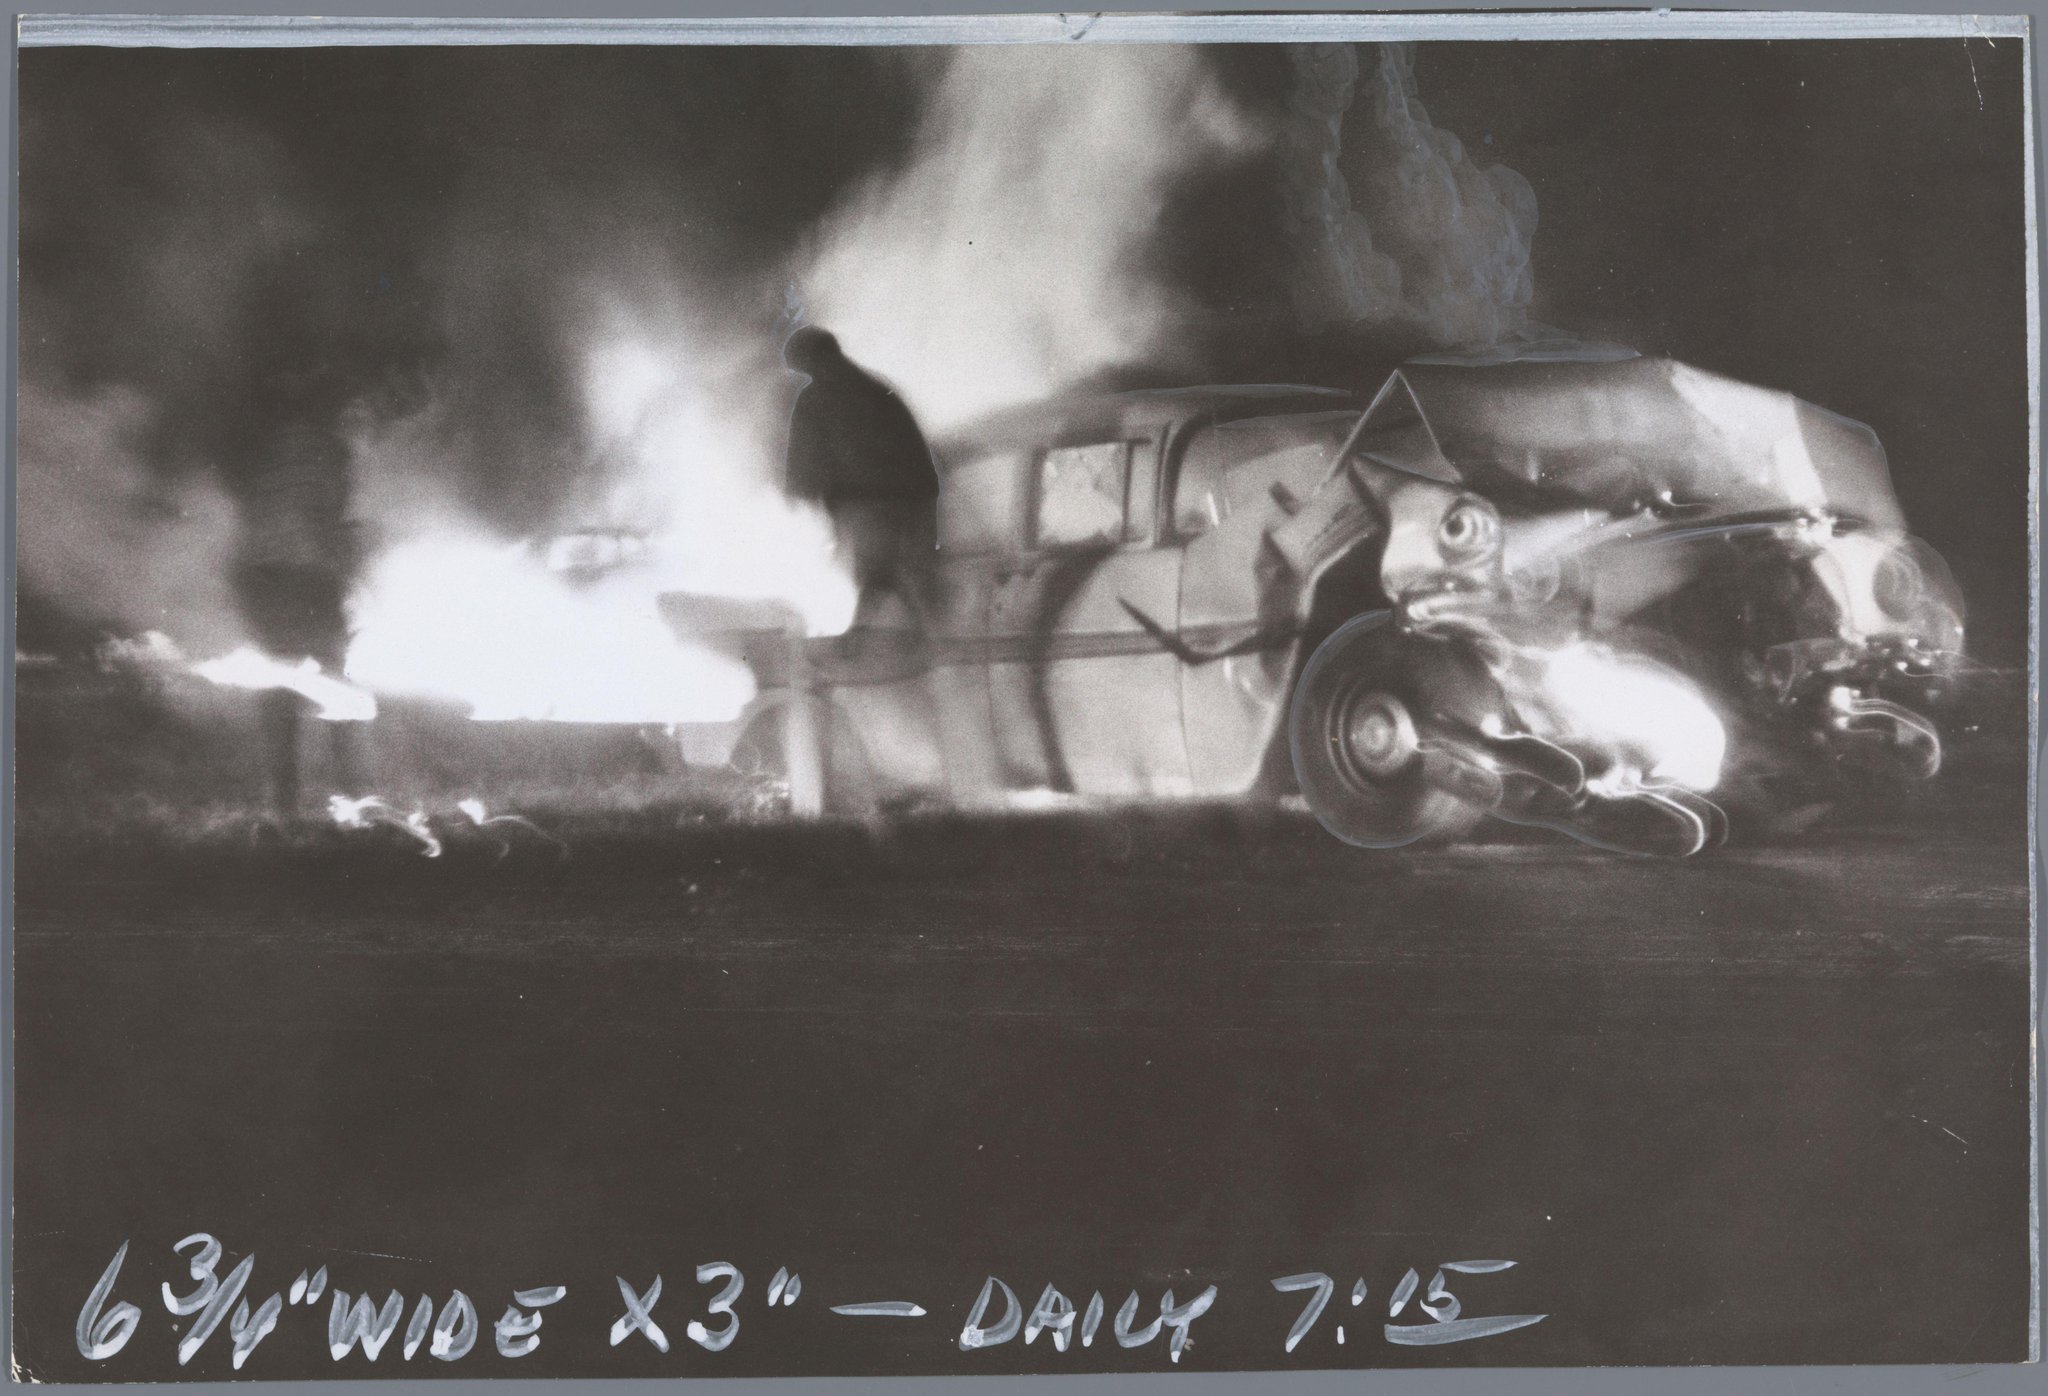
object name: photograph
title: Brandende auto's na verkeersongeluk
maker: gerald formosa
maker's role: fotograaf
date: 1965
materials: paper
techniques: gelatin silver print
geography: santa rosa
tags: accident with automobile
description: Persfoto met aanwijzingen voor de opmaker met achterop de foto zoals deze daadwerkelijk in de krant verscheen.